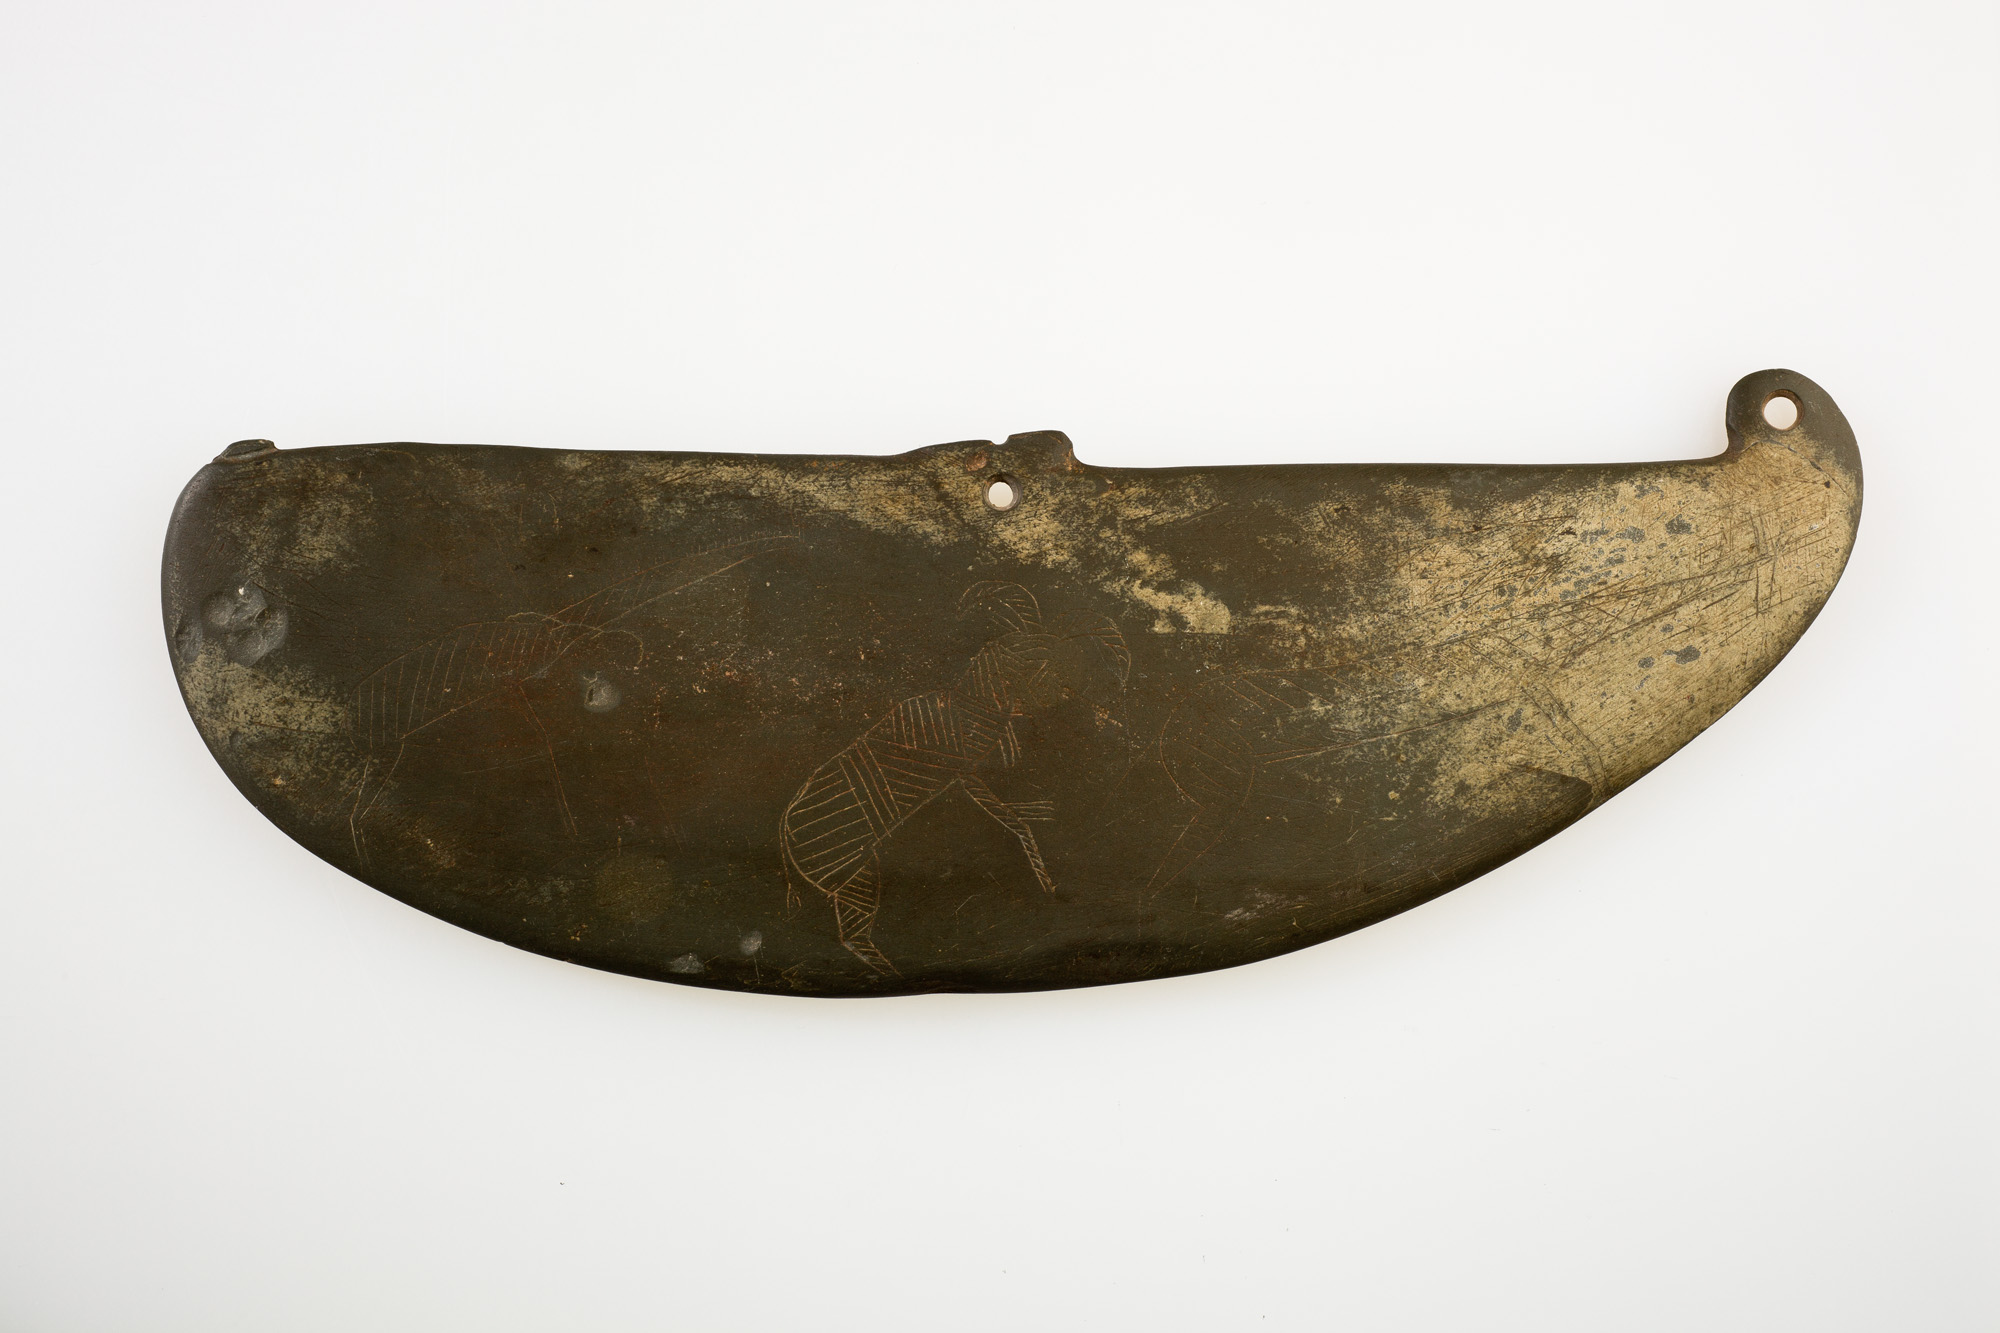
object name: palette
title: Palette with Incised Figures of Giraffes, Ibex, and Antelope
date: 3850-2960 BCE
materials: stone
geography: egypt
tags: giraffes,ibex